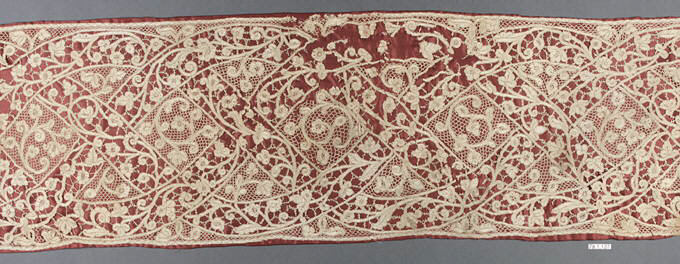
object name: band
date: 1601-1700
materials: lace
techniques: lace